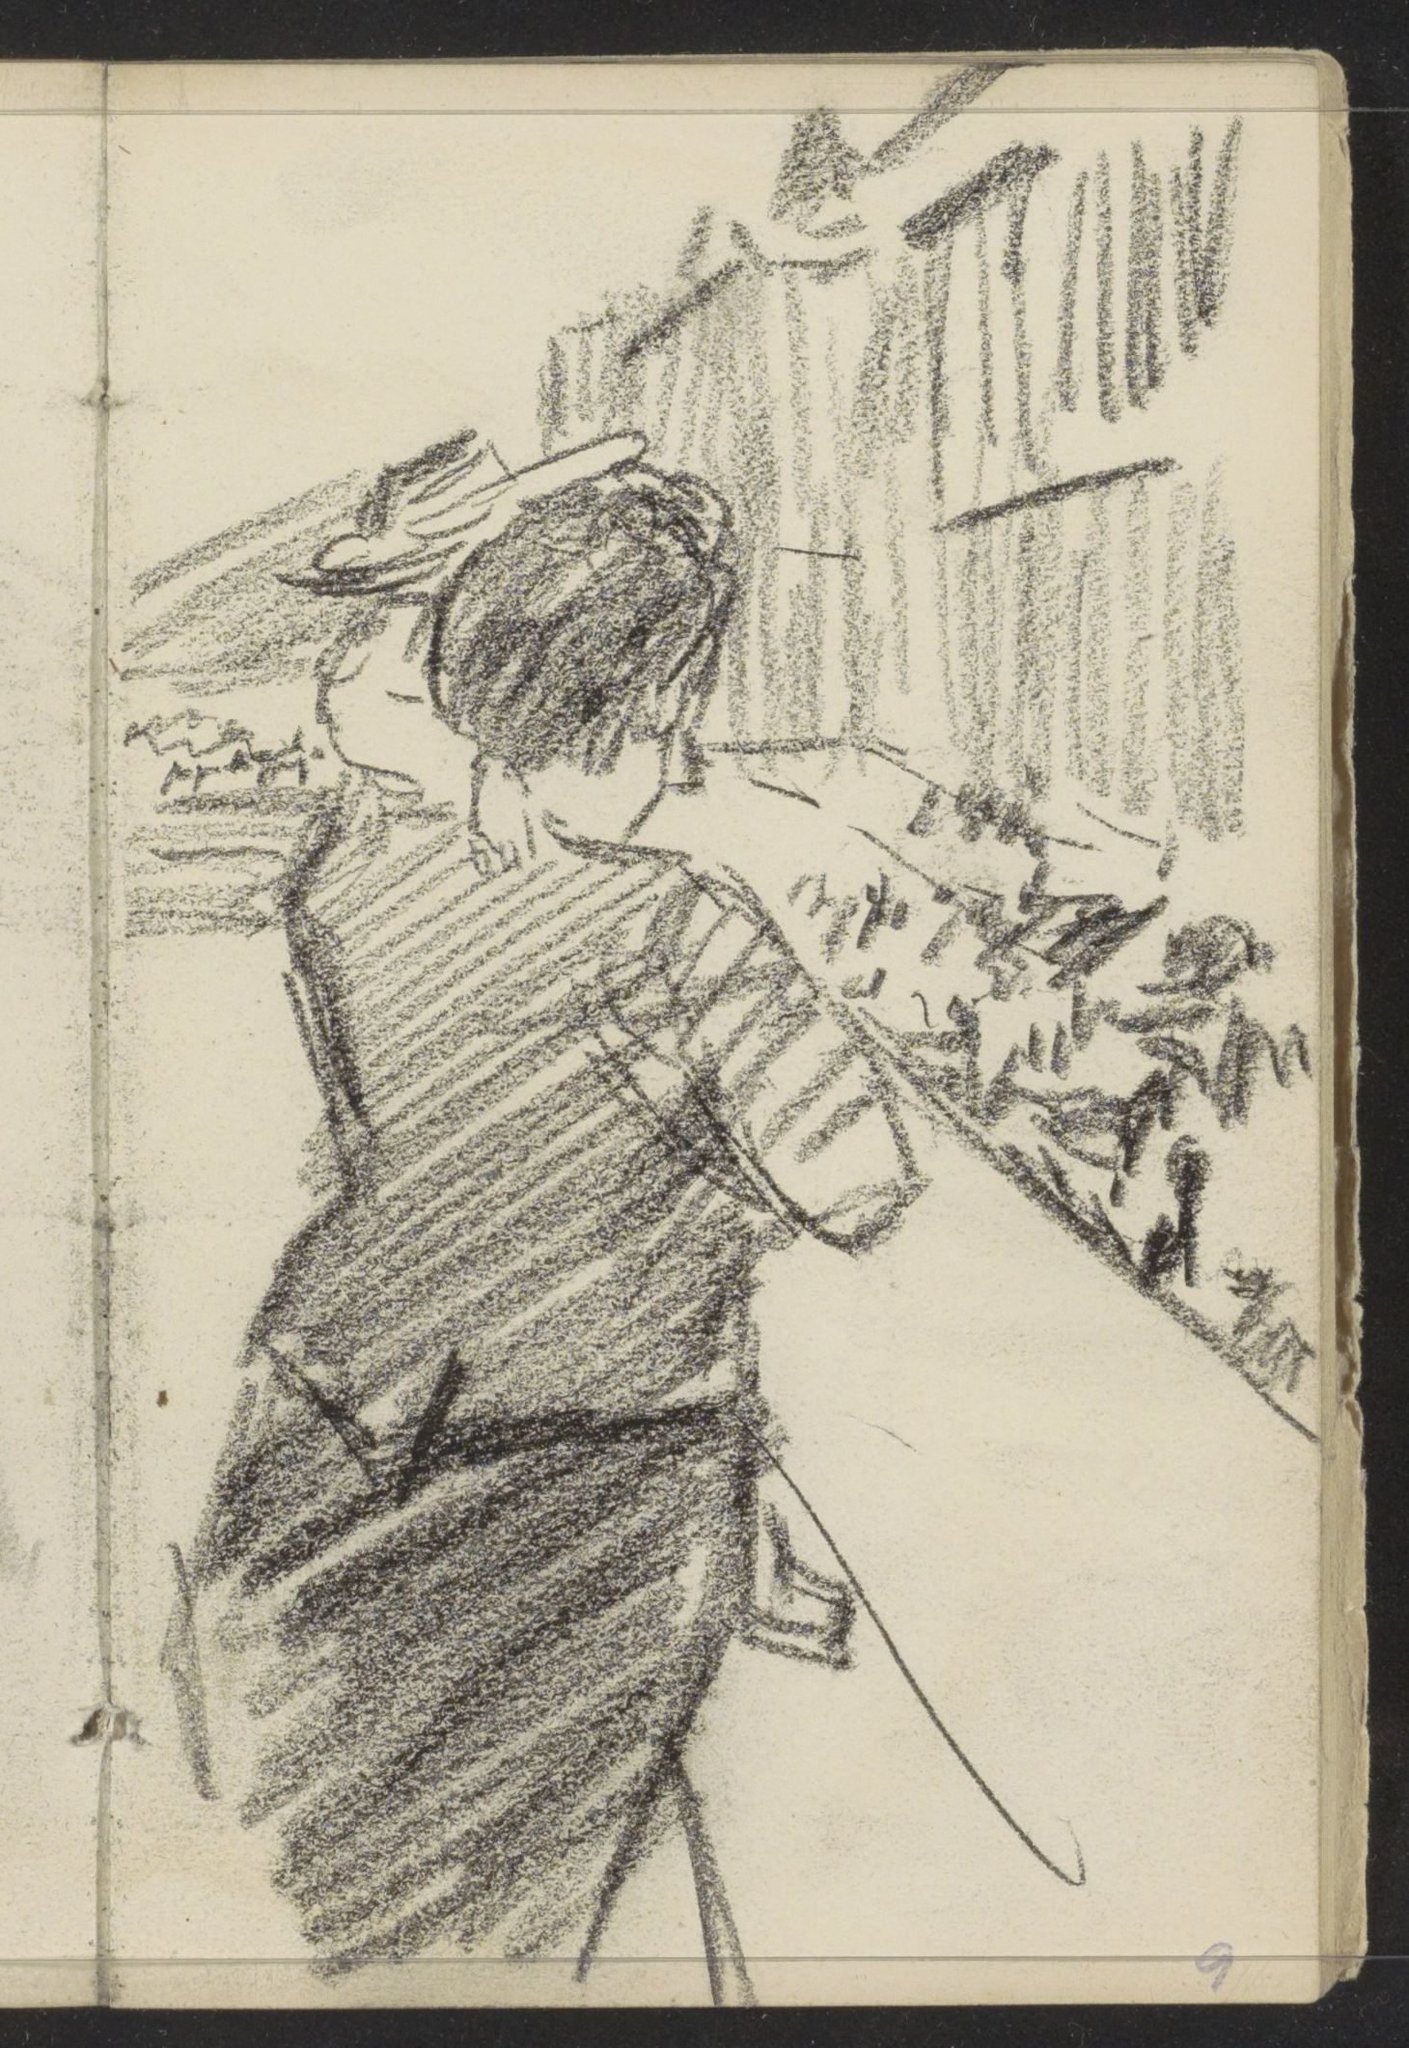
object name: sketchbook leaf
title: Vrouw met een meisje op een balkon in Parijs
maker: isaac israels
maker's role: draughtsman, painter, print maker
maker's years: 1865-1934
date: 1887-1934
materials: chalk, paper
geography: paris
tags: adult woman, girl (child between toddler and youth), balcony, street (+ city(-scape) with figures, staffage), paris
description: Ze kijken naar het verkeer op straat. Mogelijk nabij het Place de la Concorde. Blad 9 recto uit schetsboek LIX met 21 bladen.